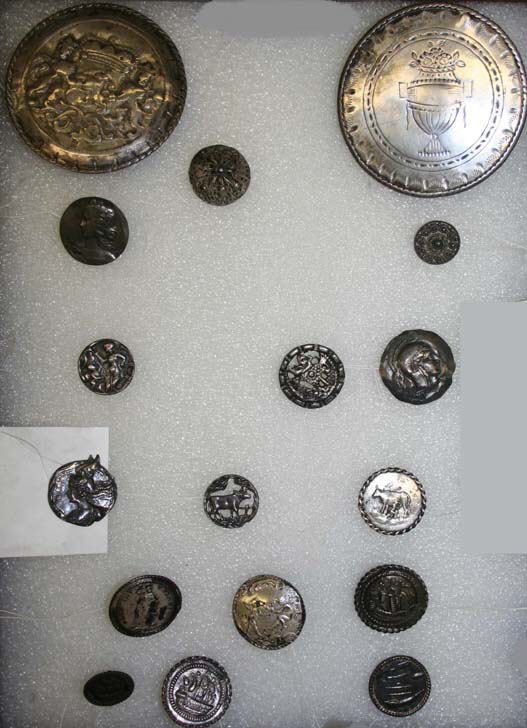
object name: button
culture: european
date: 1780-1890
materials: metal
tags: cows,ships